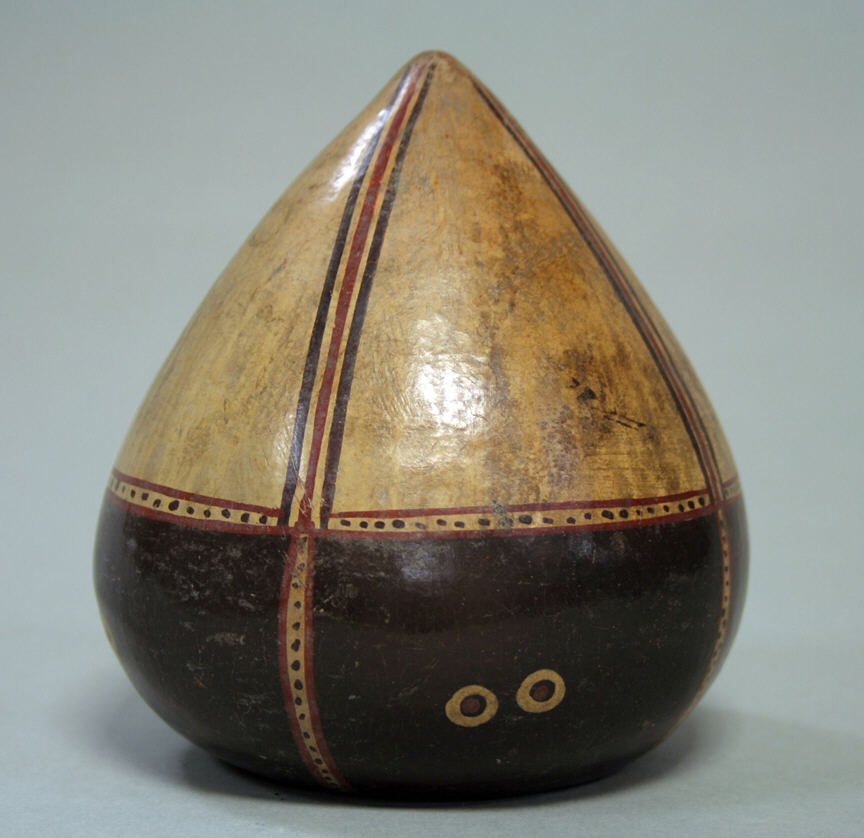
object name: bowl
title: Painted Bowl with Pointed Base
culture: nasca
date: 301-600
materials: ceramic, pigment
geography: peru